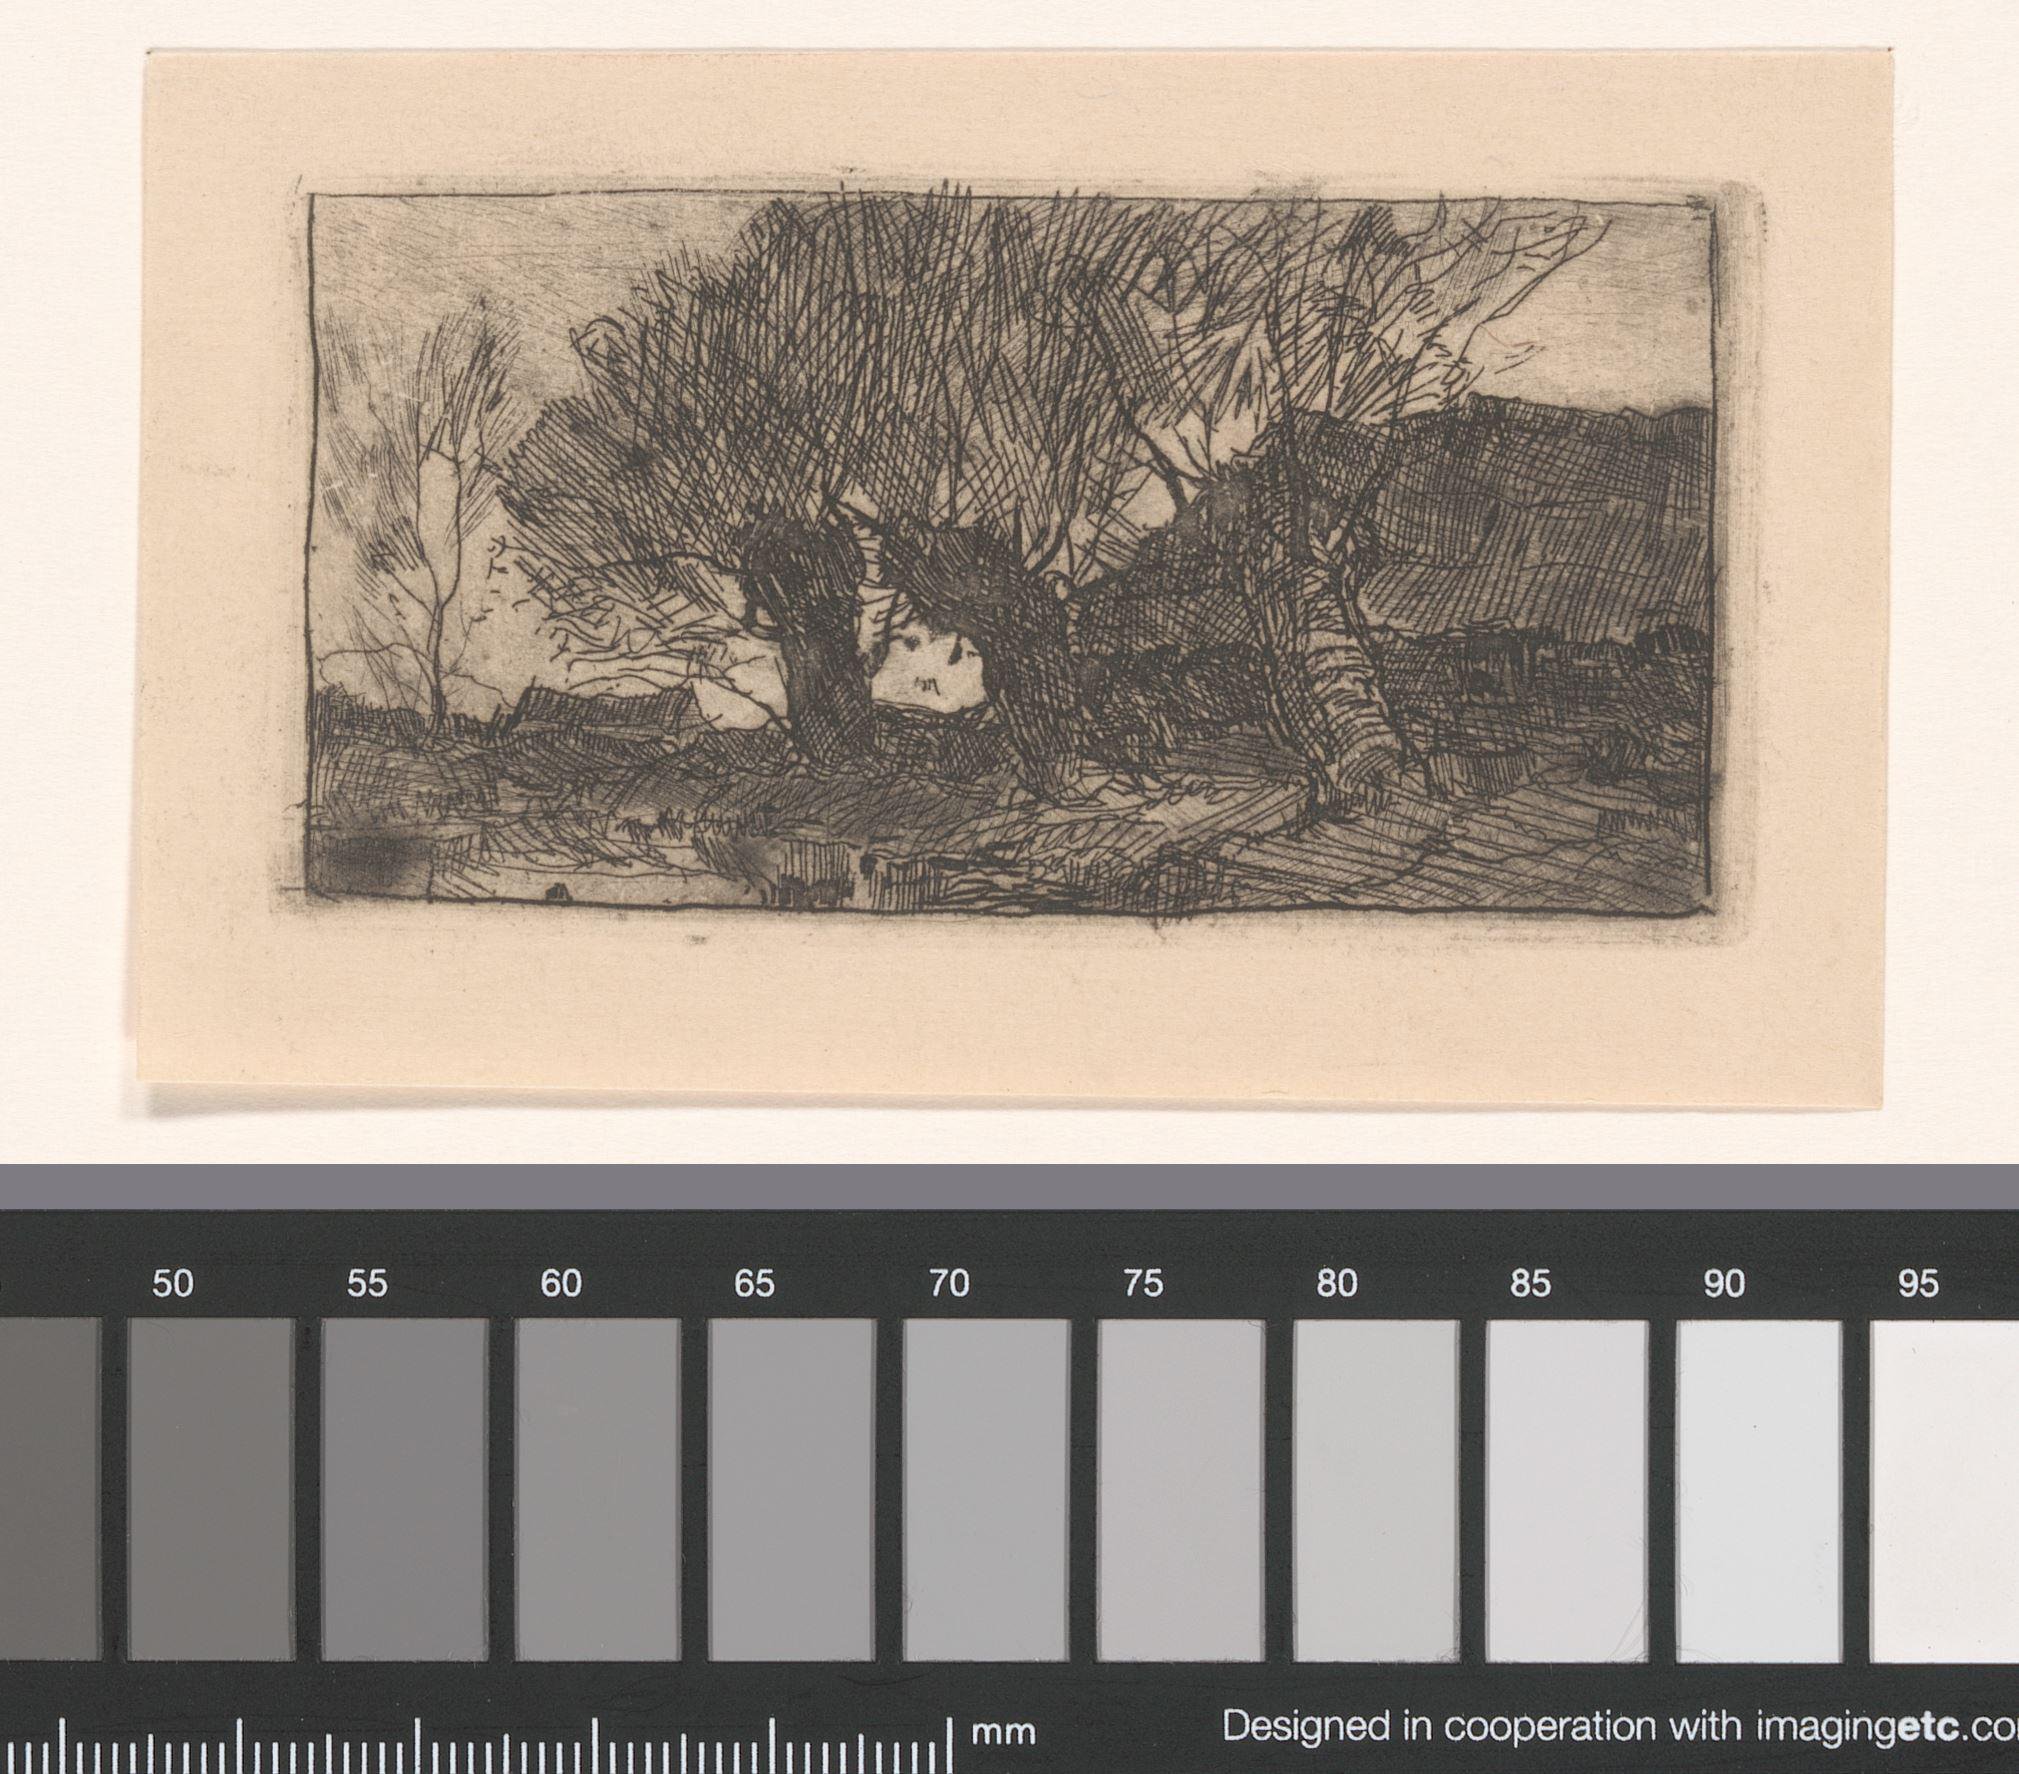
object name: print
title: Drie knotwilgen bij een boerderij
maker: chris van der windt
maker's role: print maker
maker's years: 1877-1952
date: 1887-1952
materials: paper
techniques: drypoint, etching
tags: farm or solitary house in landscape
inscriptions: collector's mark: Lugt 2228